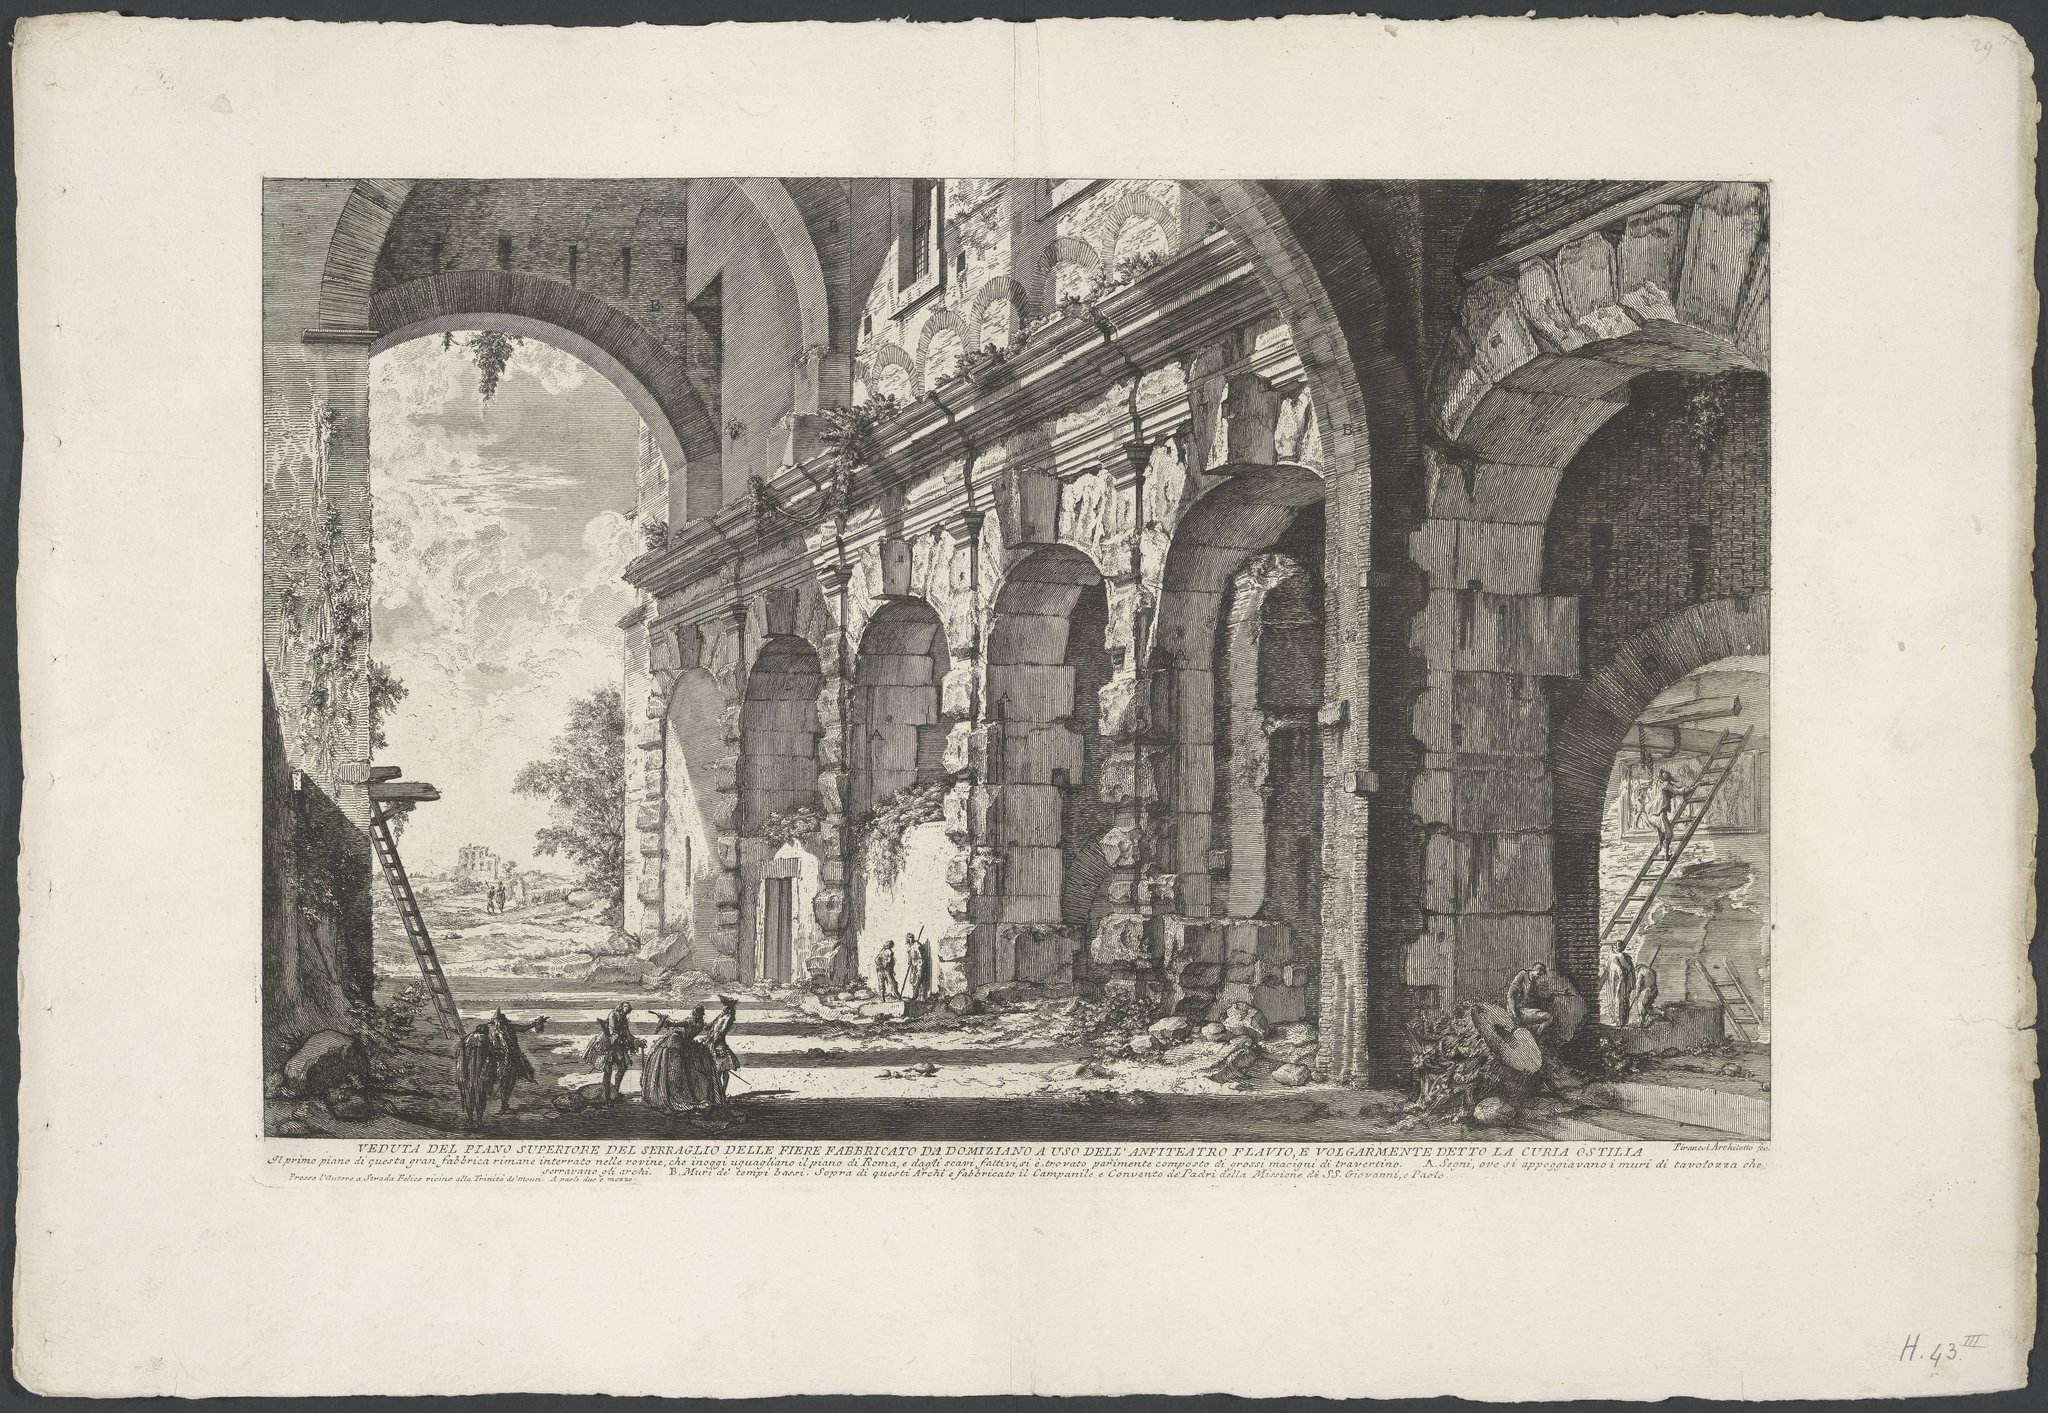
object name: print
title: Gezichten op Rome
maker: giovanni battista piranesi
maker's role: designer, draughtsman, print maker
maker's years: 1720-1778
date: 1748-1778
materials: paper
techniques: etching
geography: rome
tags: ruin of a building ~ architecture, landscape with ruins, roman catholic church, rome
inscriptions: collector's mark: Lugt 2228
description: Deze prent maakt deel uit van de serie 'Vedute di Roma'. Piranesi werkte aan deze 135 platen tellende serie tussen 1748 en zijn dood in 1778. Francesco Piranesi voegde later nog twee prenten toe aan de reeks van zijn vader.